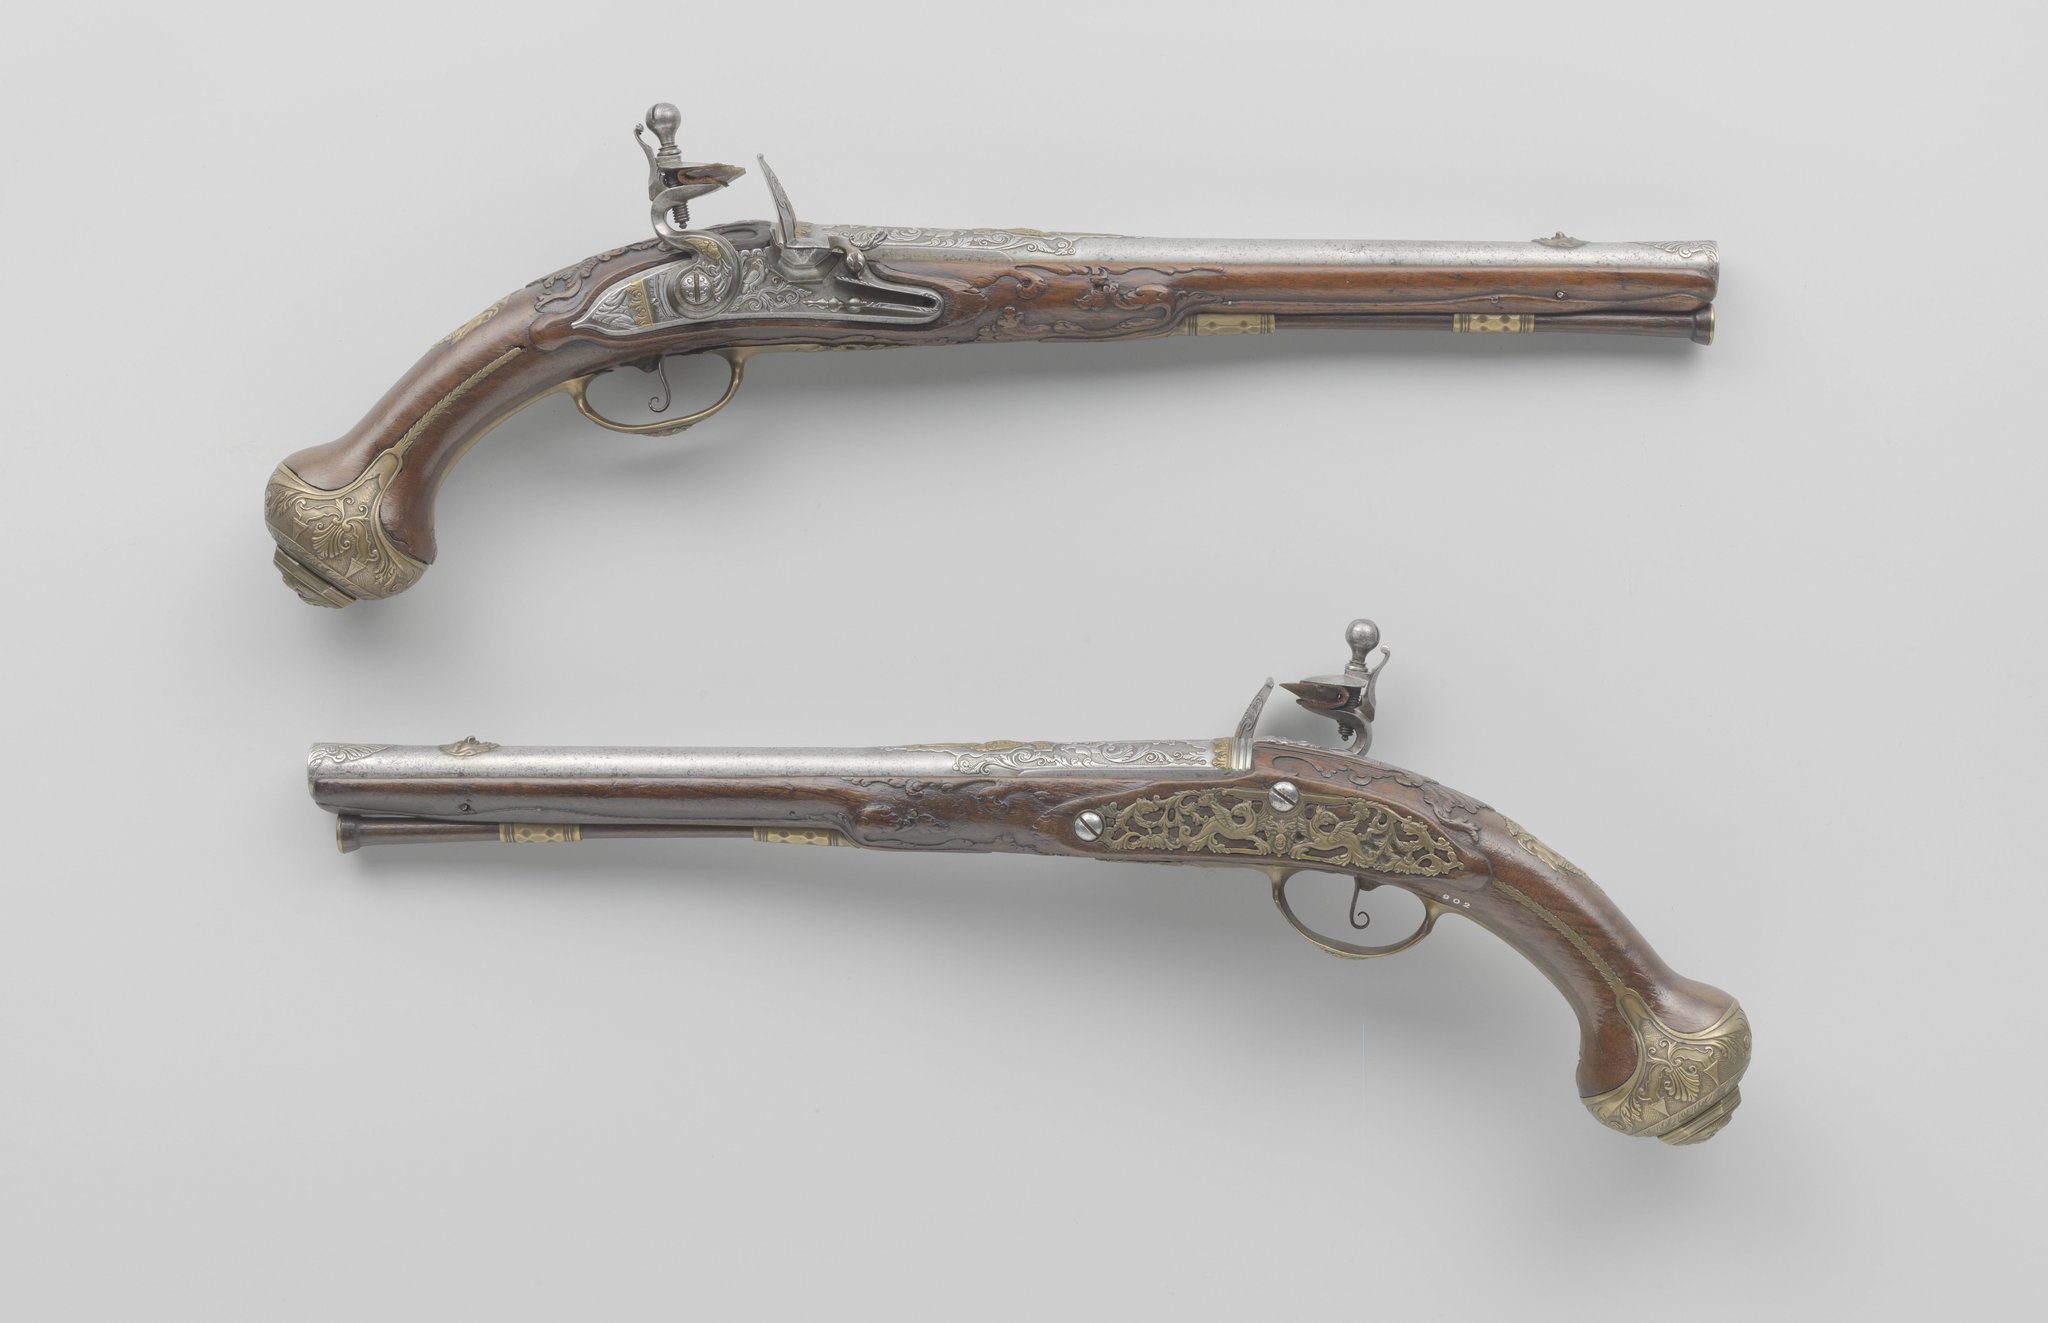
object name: flintlock pistol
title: Vuursteenpistool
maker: barend penterman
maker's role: geweermaker, pistoolmaker, vuursteenslotmaker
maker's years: -1723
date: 1720-1725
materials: brass, stone, silver, wood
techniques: printing, metalworking, cutting, embroidery, engraving, gilding, granulation, relief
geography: utrecht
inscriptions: coat of arms, signature: ‘PENTERMAN’, inscription: ‘UTRECHT’